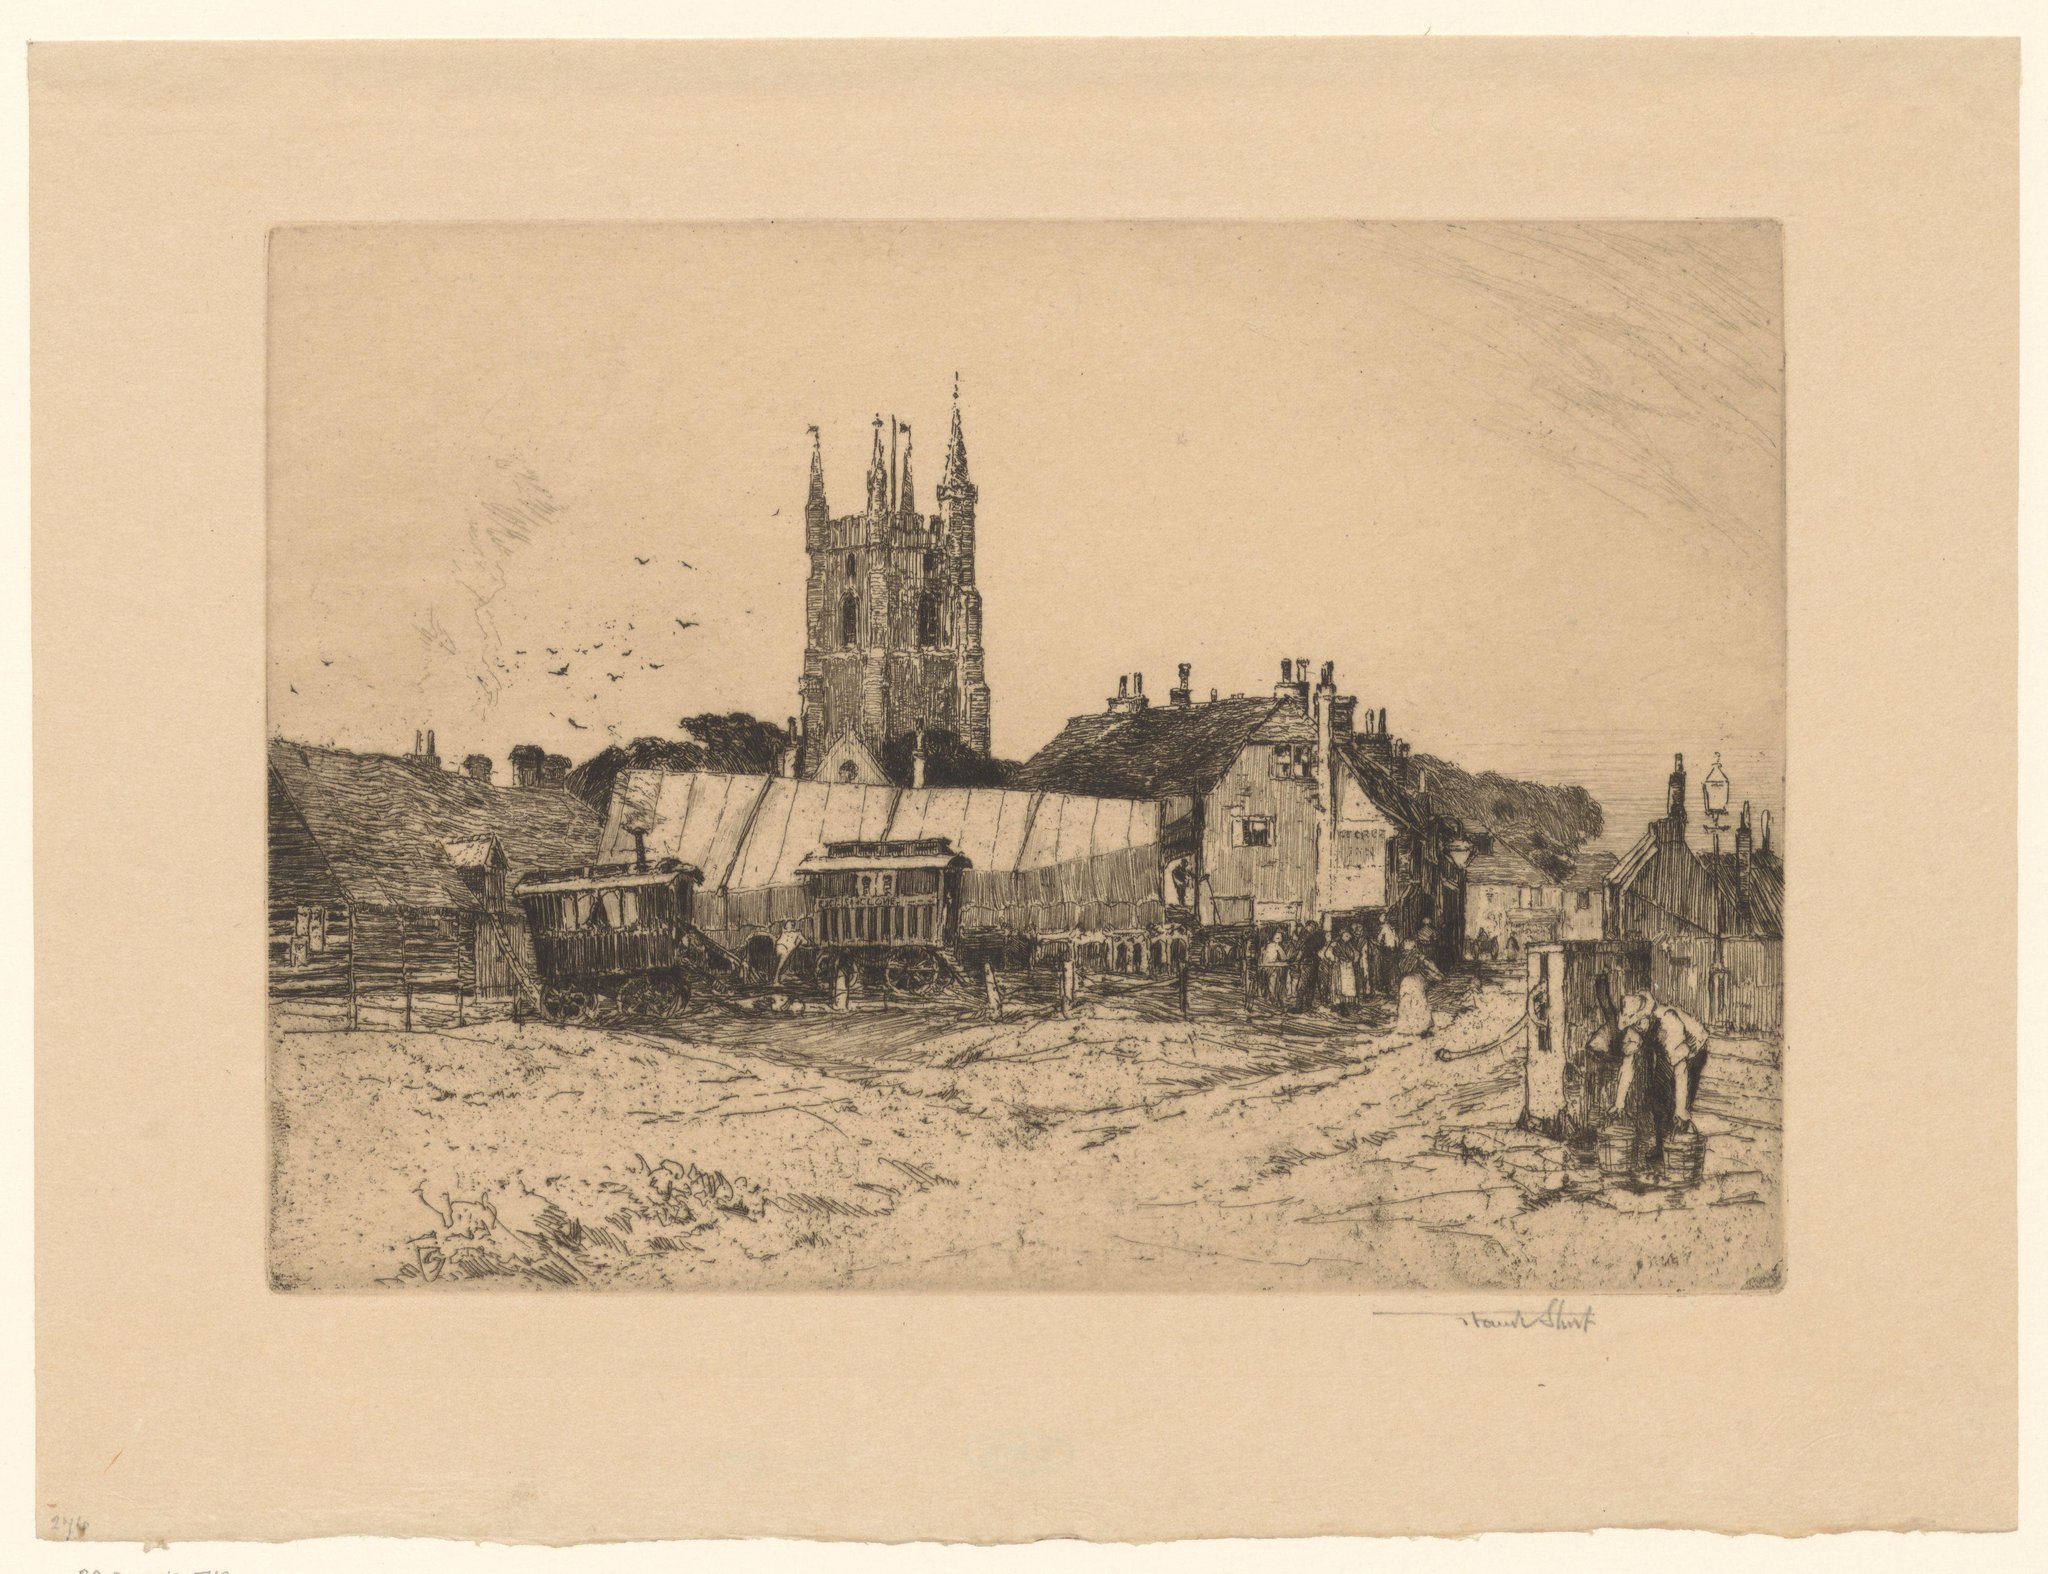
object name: print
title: Strolling Players, Lydd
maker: frank short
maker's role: print maker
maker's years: 1857-1945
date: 1907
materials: paper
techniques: etching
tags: troupe (actors) 'en route', wandering communities living in house-wagons, church (exterior)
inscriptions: signature: ‘Frank Short’, collector's mark: Lugt 2228